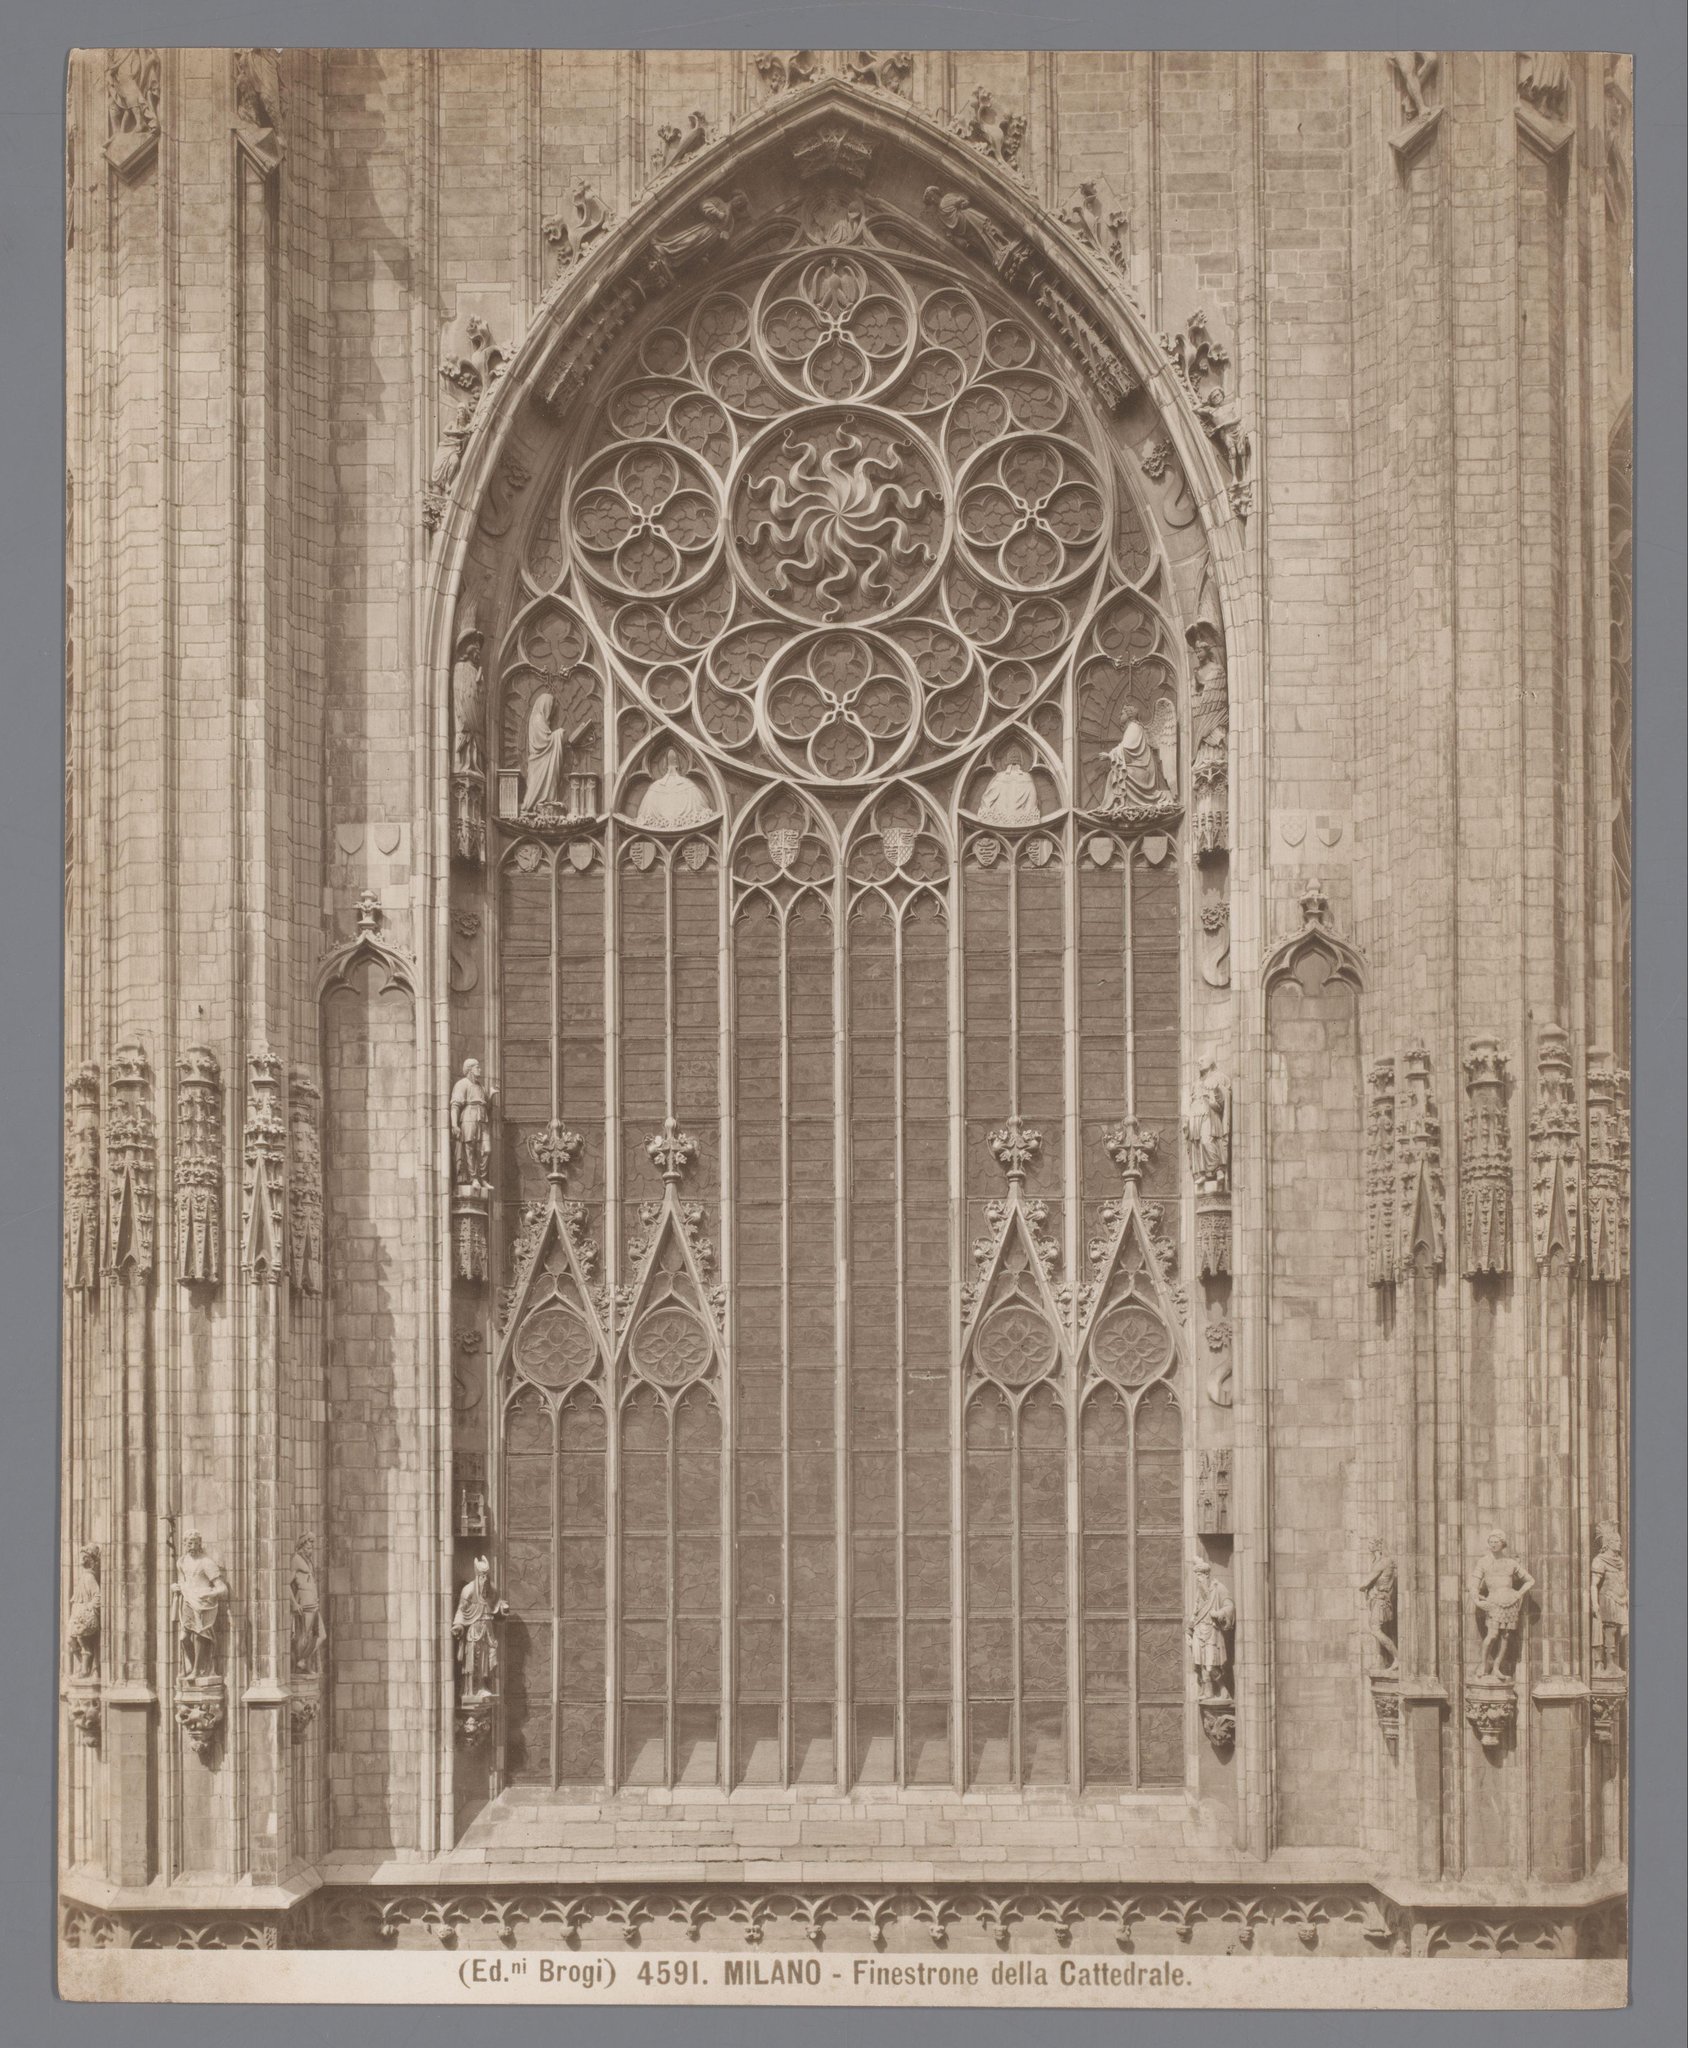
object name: photograph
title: Venster van de kathedraal van Milaan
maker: giacomo brogi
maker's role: fotograaf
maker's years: 1822-1881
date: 1890-1920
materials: paper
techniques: gelatin silver print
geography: milan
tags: parts of church exterior and annexes, balcony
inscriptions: number: ‘4591.’, collector's mark: ‘VOSMAER’